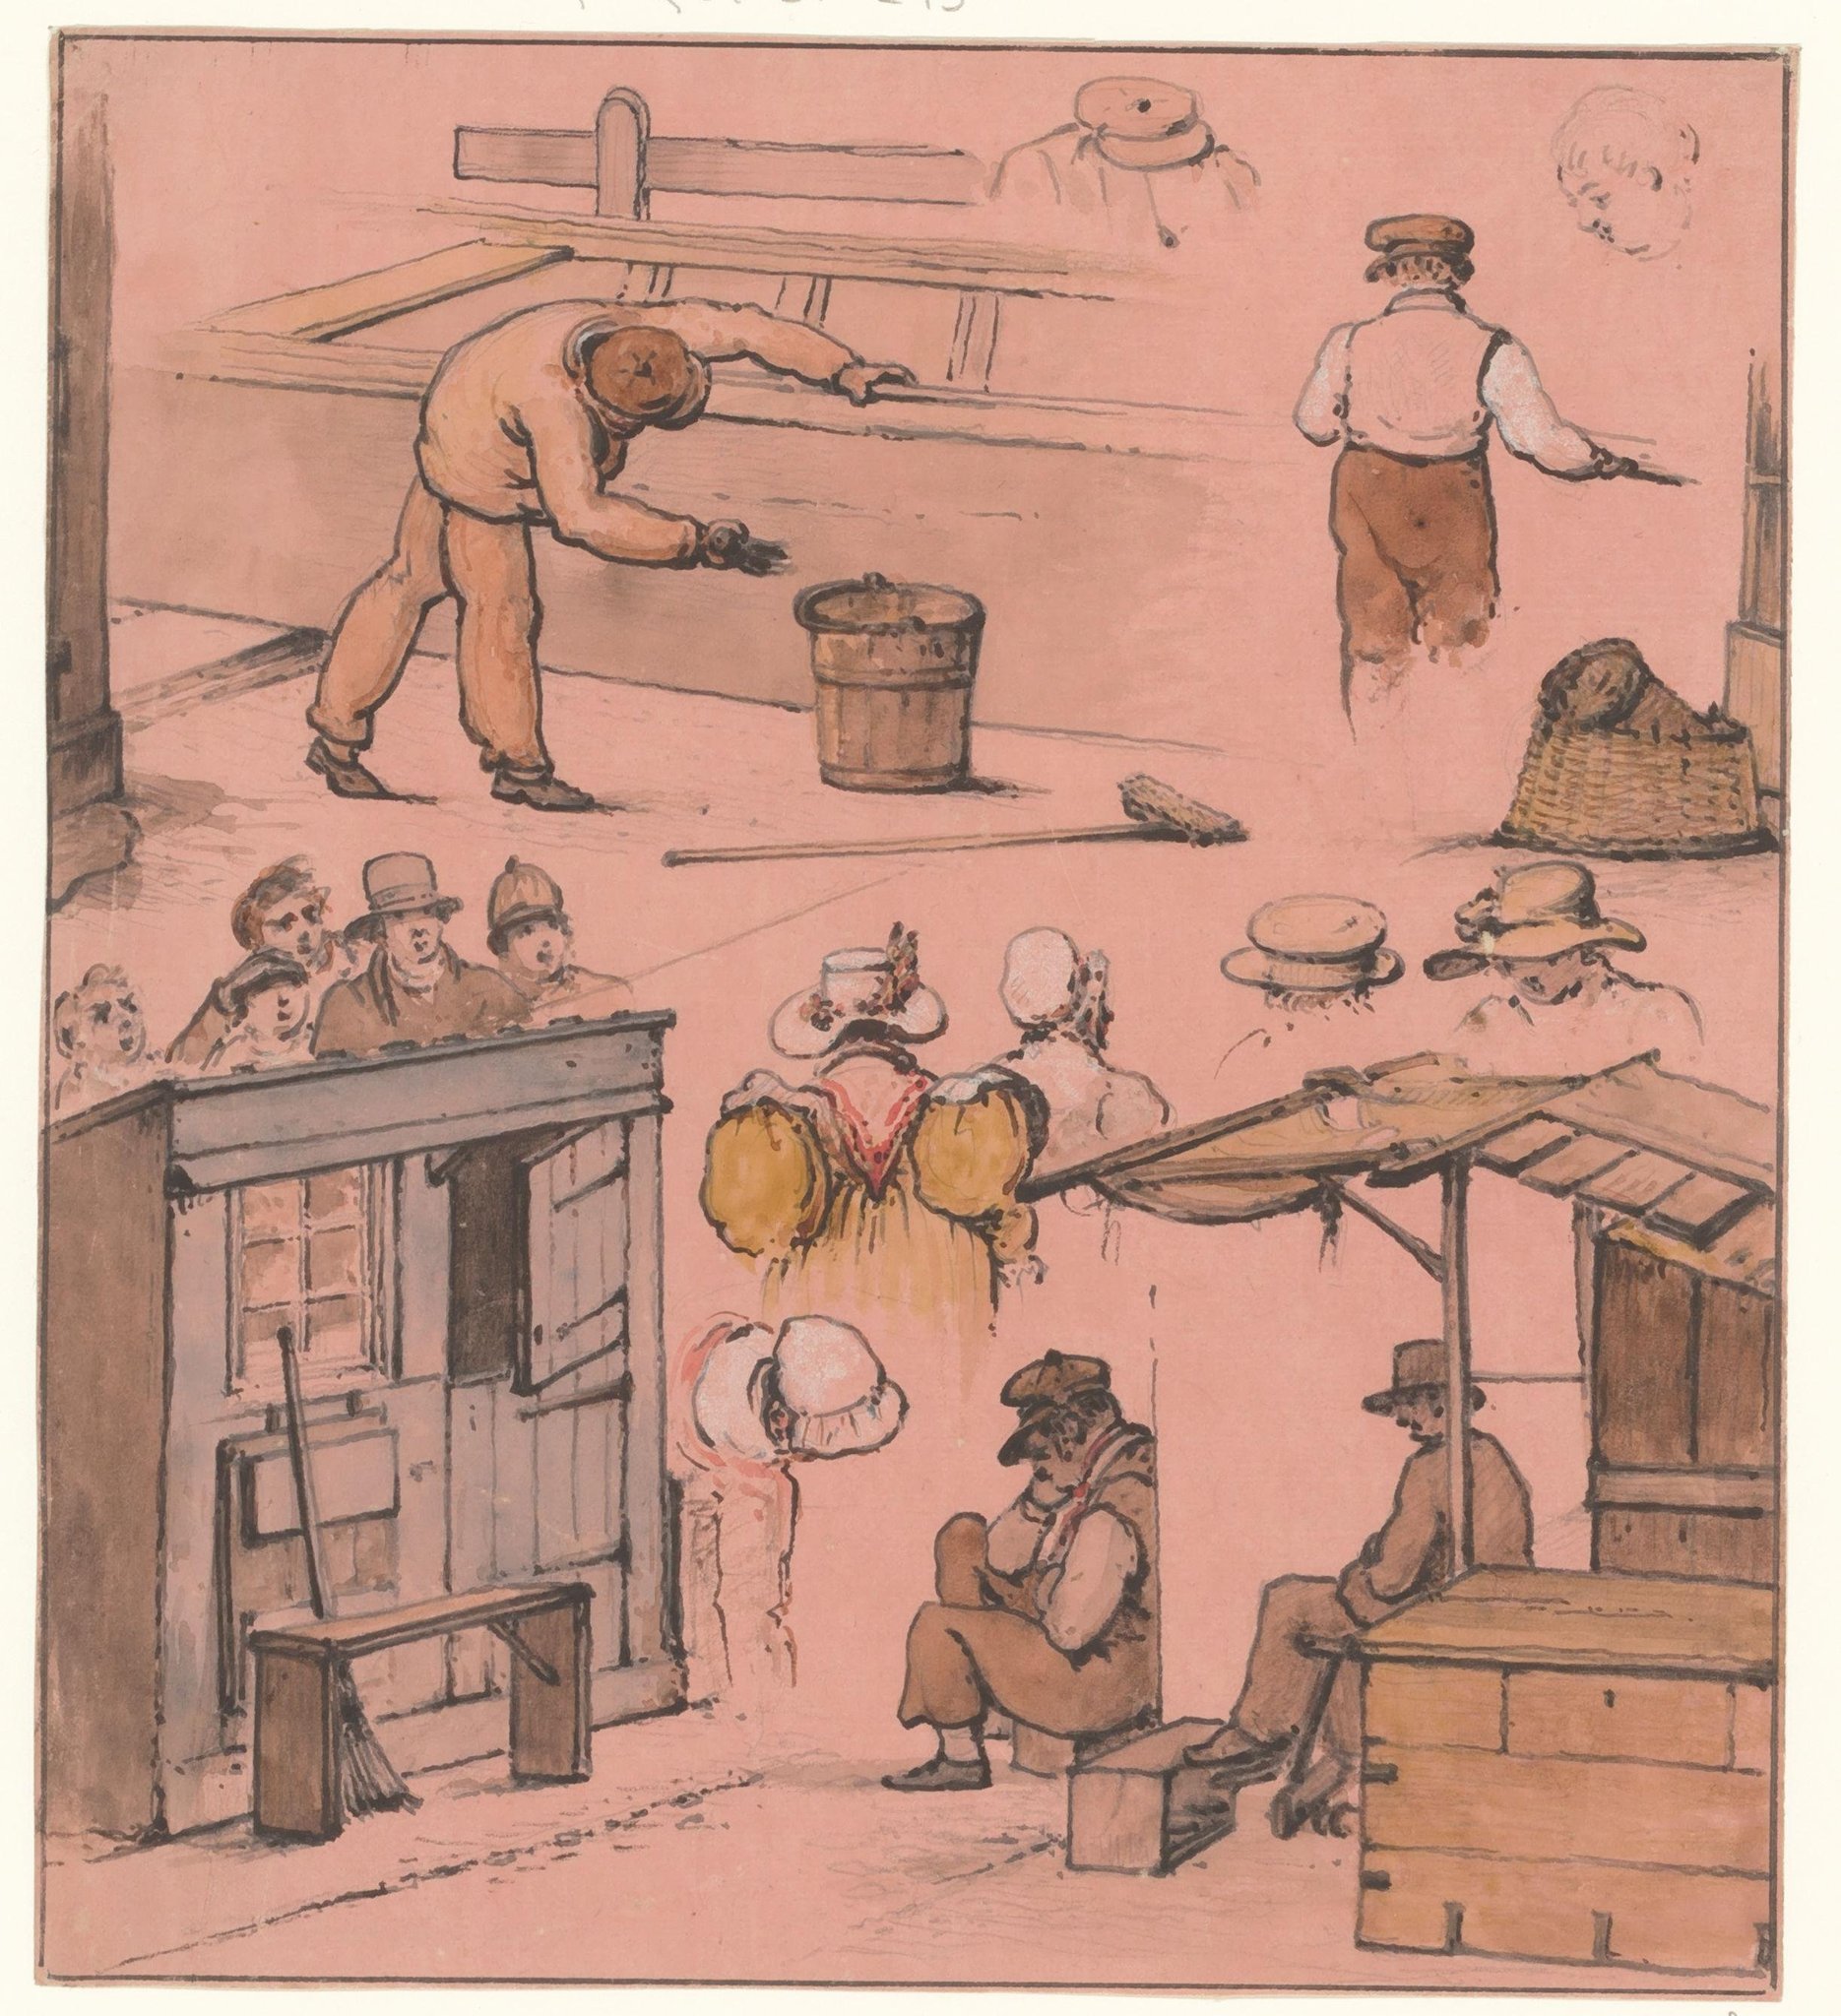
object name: drawing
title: Schetsblad met verschillende stadstypes, waaronder een schoenpoetsers en koekkraam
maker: christiaan andriessen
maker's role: draughtsman, print maker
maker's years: 1775-1846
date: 1785-1846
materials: paint, ink, paper, watercolor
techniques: brush, pen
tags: handicrafts, craftsman at work, shoe-maker, cobbler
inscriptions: stamp, collector's mark: Lugt 1641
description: Onderwerpsrubrieken binnen de Atlas Zeden en Gewoonten: Zeden en Gewoonten in Engeren Zin, De Kleeding, Kleederdrachten (tijdvakken), Het begin der 19de eeuw. Teekeningen van Christiaan Andriessen, † 1819. mannen en vrouwen. stadstypen.